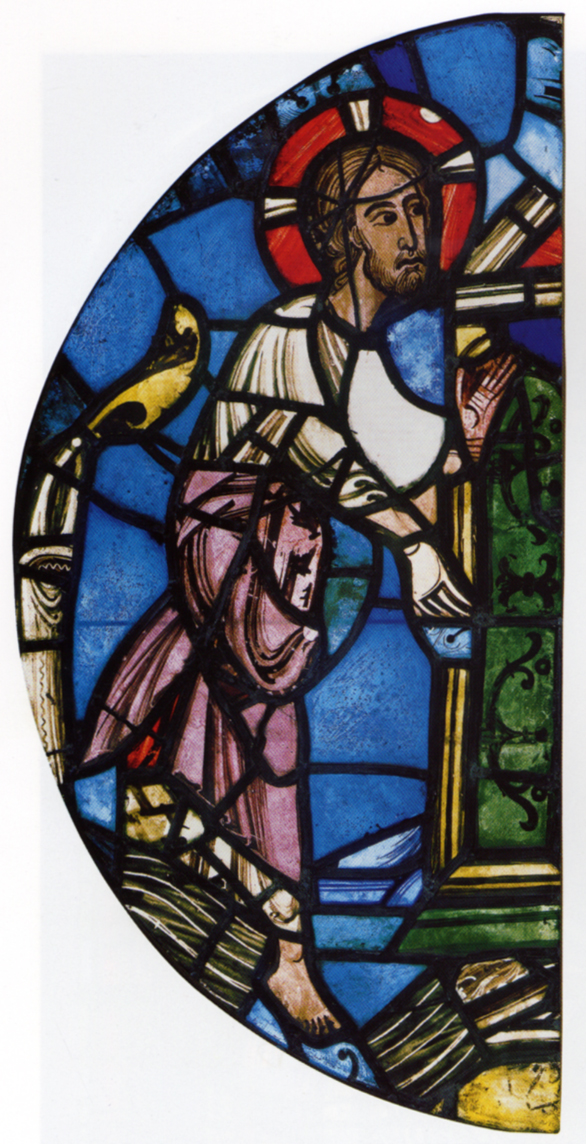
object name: panel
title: God Closing the Door of Noah’s Ark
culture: french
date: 1190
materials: glass, lead, metal, paint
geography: france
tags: god the father